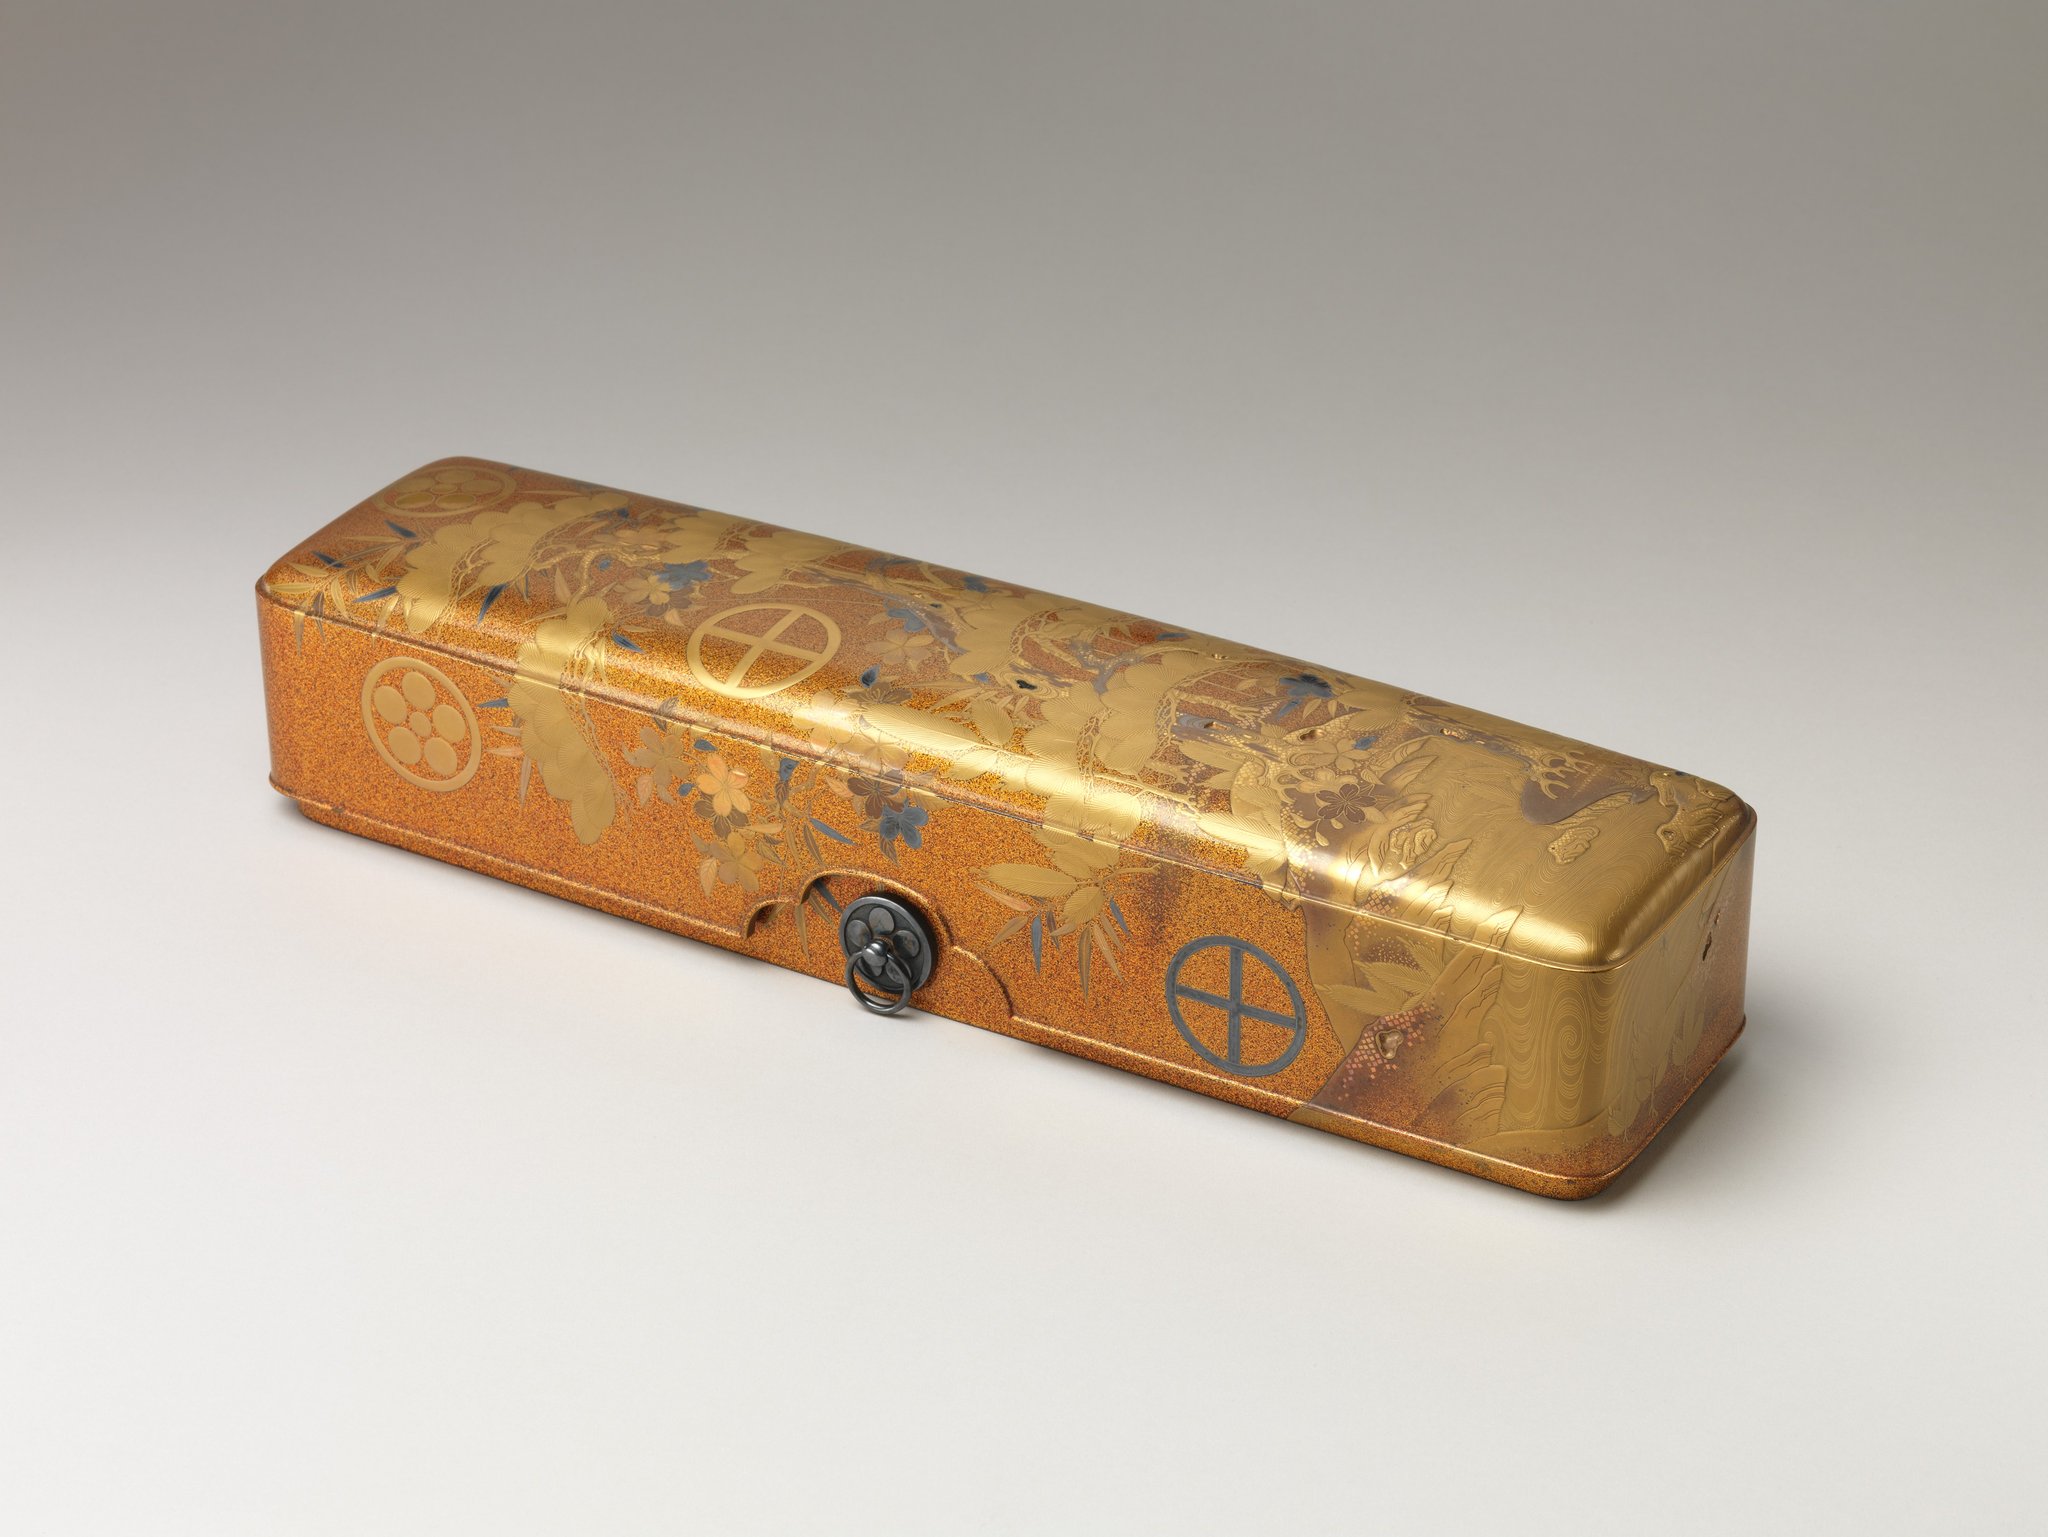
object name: letter box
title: Letter Box with Pine, Bamboo, Plum Blossom, and Family Crests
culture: japanese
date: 1801-1900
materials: gold, gold foil, silver, wood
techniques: cutting, hiramakie, lacquer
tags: flowers